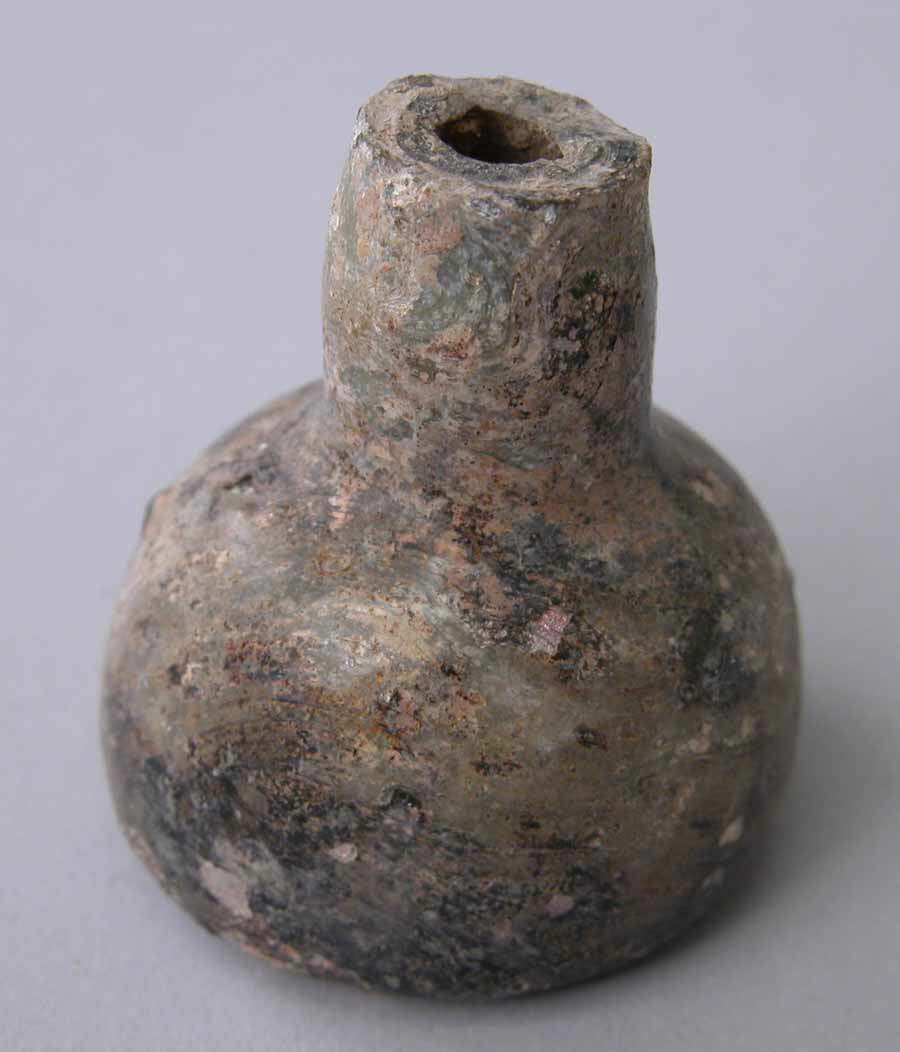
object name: bottle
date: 601-800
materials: glass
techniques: glassblowing, tooling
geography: iraq